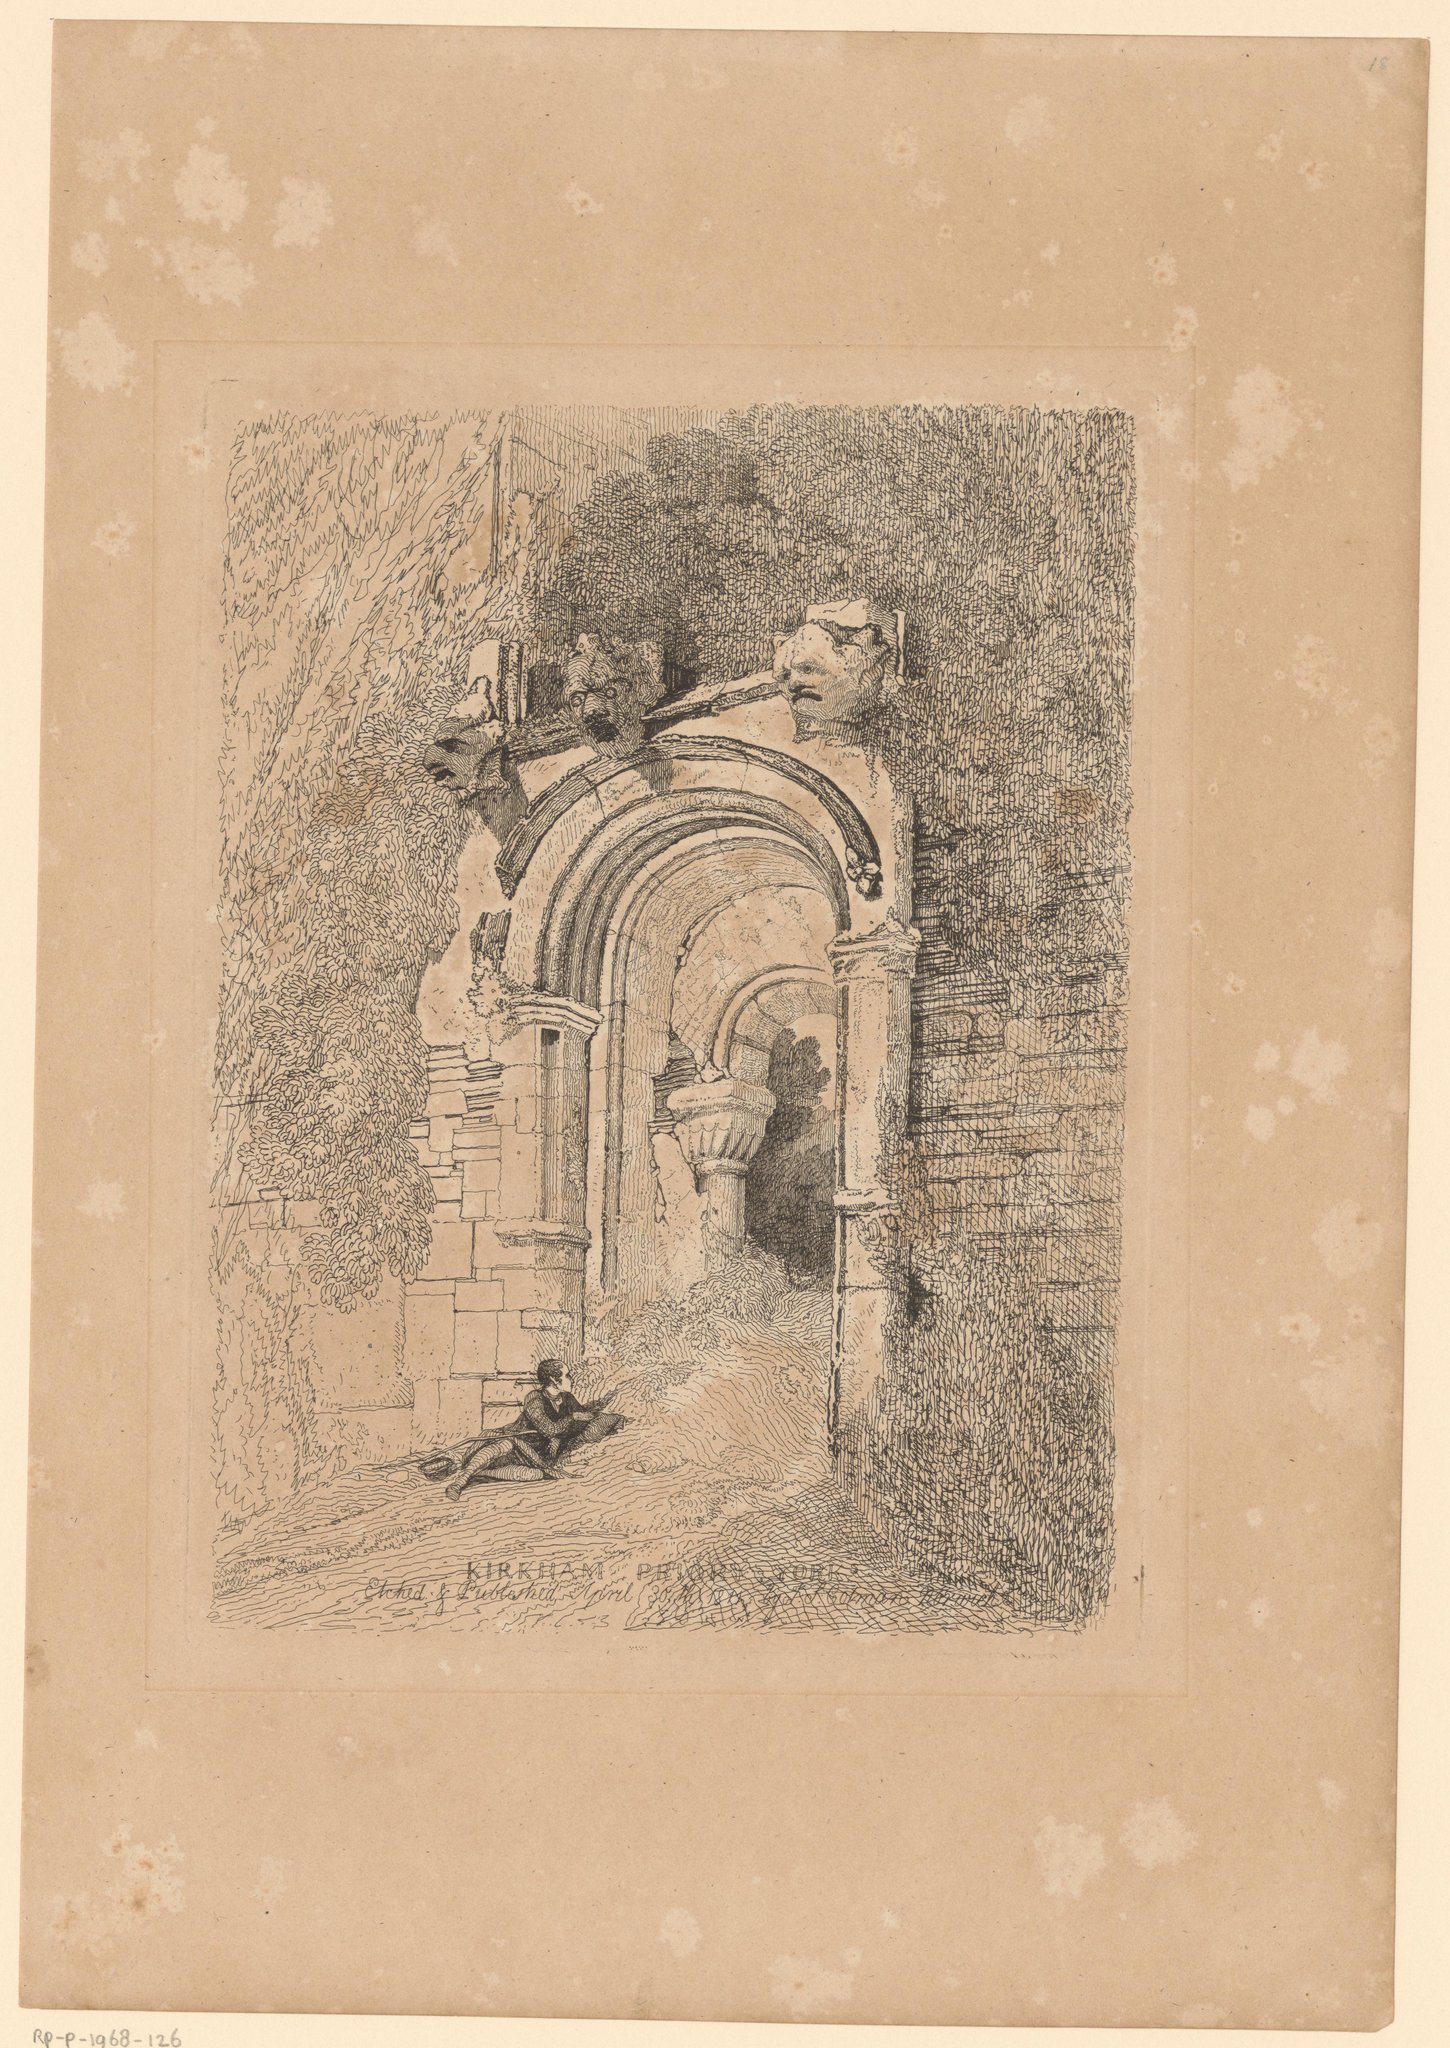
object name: print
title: Man ligt bij een poort van de ruïne van de priorij van Kirkham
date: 1811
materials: paper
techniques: etching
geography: edinburgh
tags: gate, entrance, ruin of church, monastery, etc., lying on one side, with uplifted upper part of the body and leaning on the arm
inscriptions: collector's mark: Lugt 2228, collector's mark: Lugt 2760